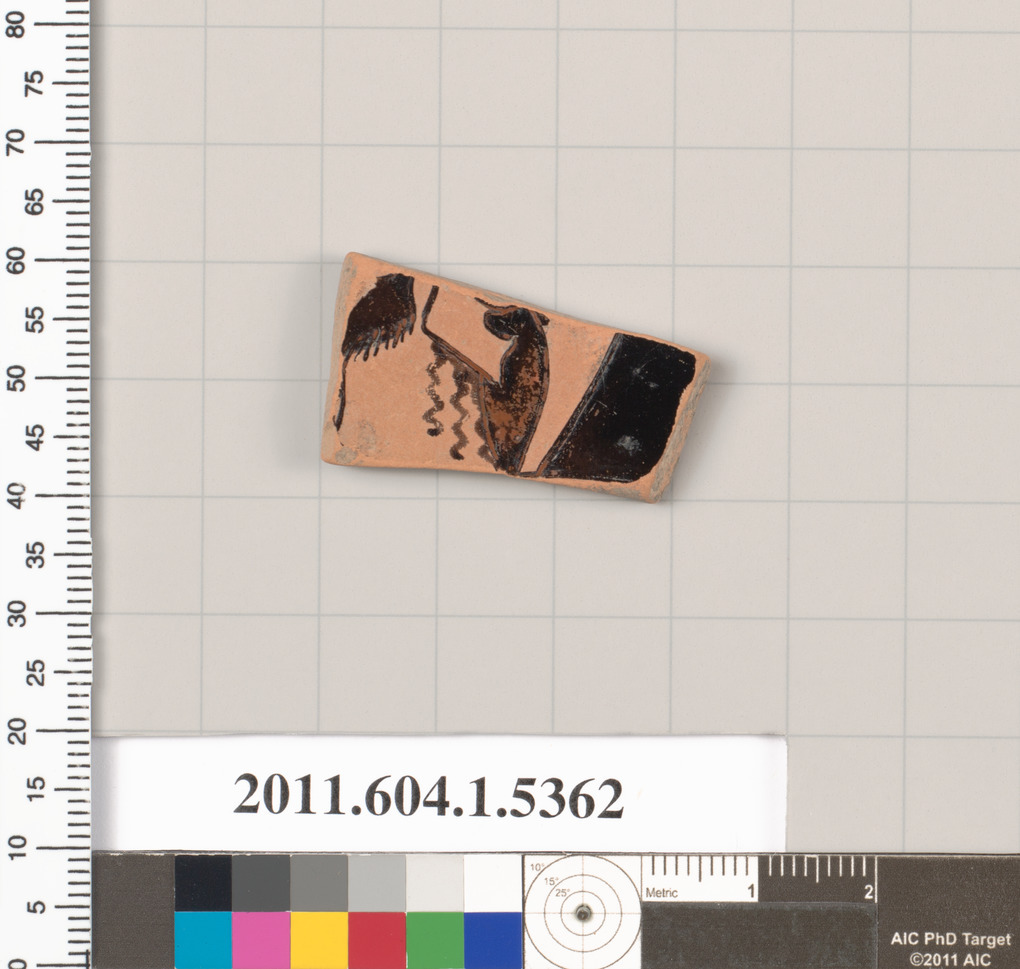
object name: kylix fragment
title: Terracotta fragment of a kylix (drinking cup)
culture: greek, attic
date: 475-451 BCE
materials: terracotta